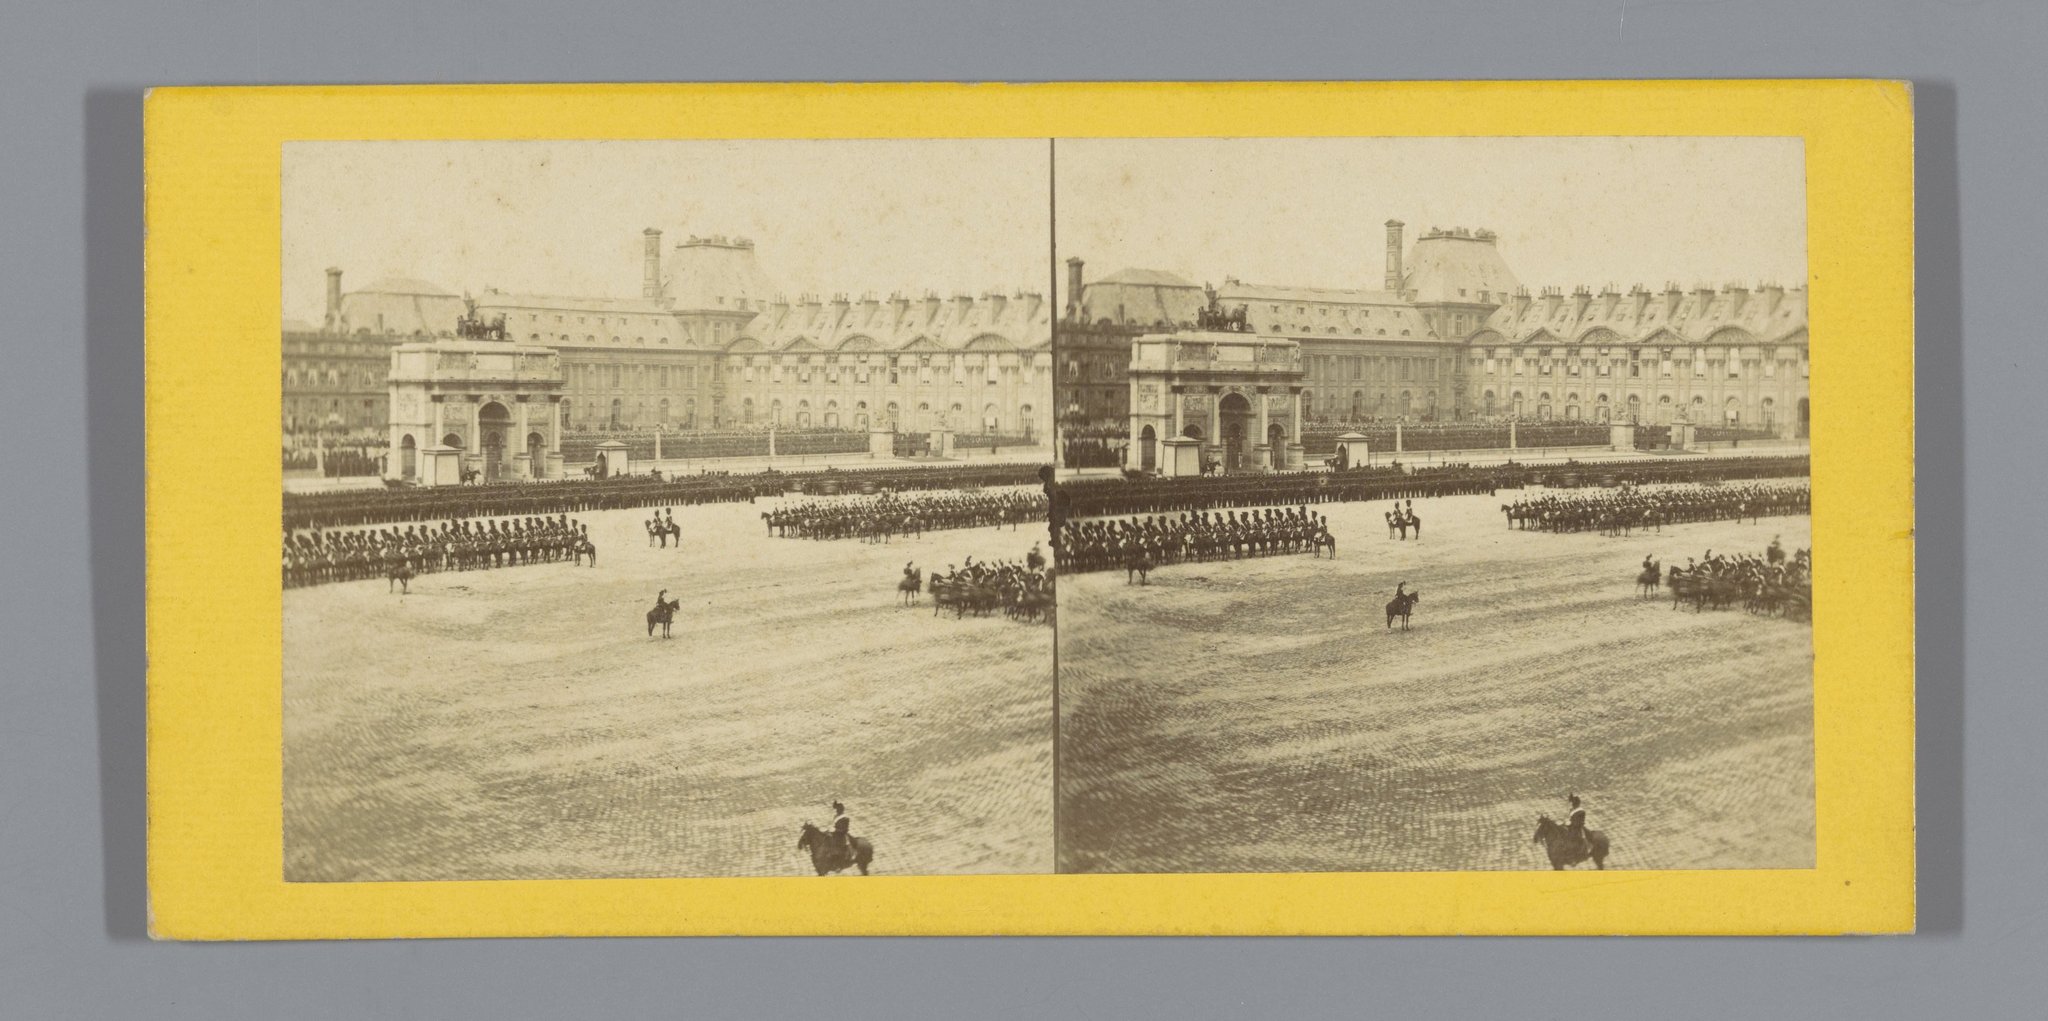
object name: stereograph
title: Opstelling van cavaleristen op het Place du Carrousel te Parijs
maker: Anonymous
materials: cardboard, photographic support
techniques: albumen print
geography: place du carrousel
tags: riding a horse, ass, or mule; rider, horseman, square, place, circus, etc., triumphal arch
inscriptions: name: ‘Place du Carousel.’